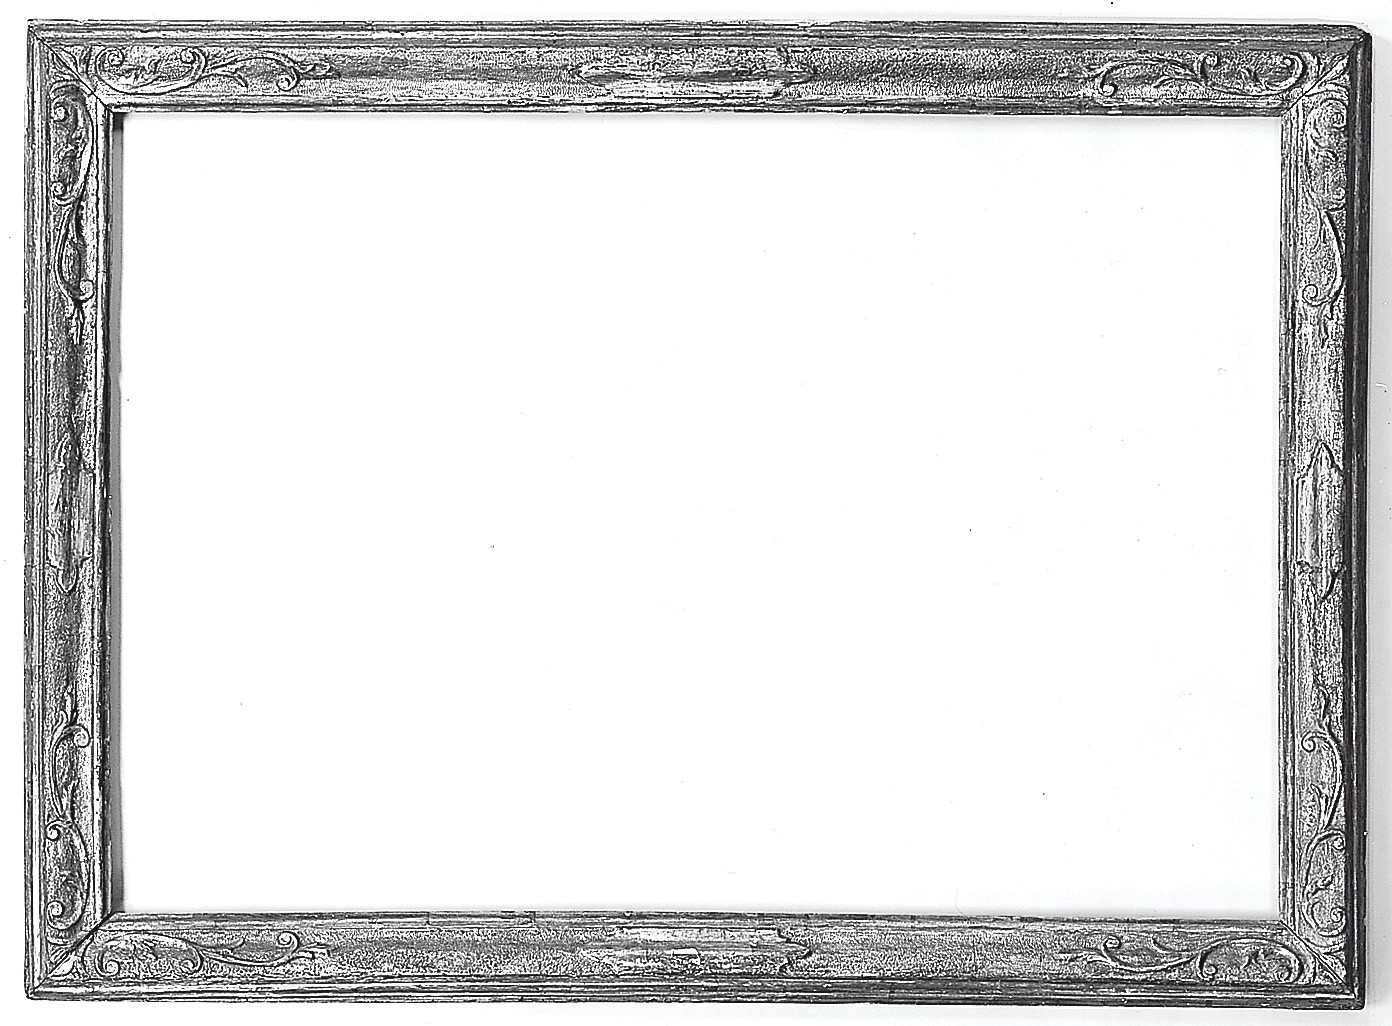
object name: frame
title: Caneletto-style frame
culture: italian, veneto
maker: italian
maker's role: artist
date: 1734-1766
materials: wood